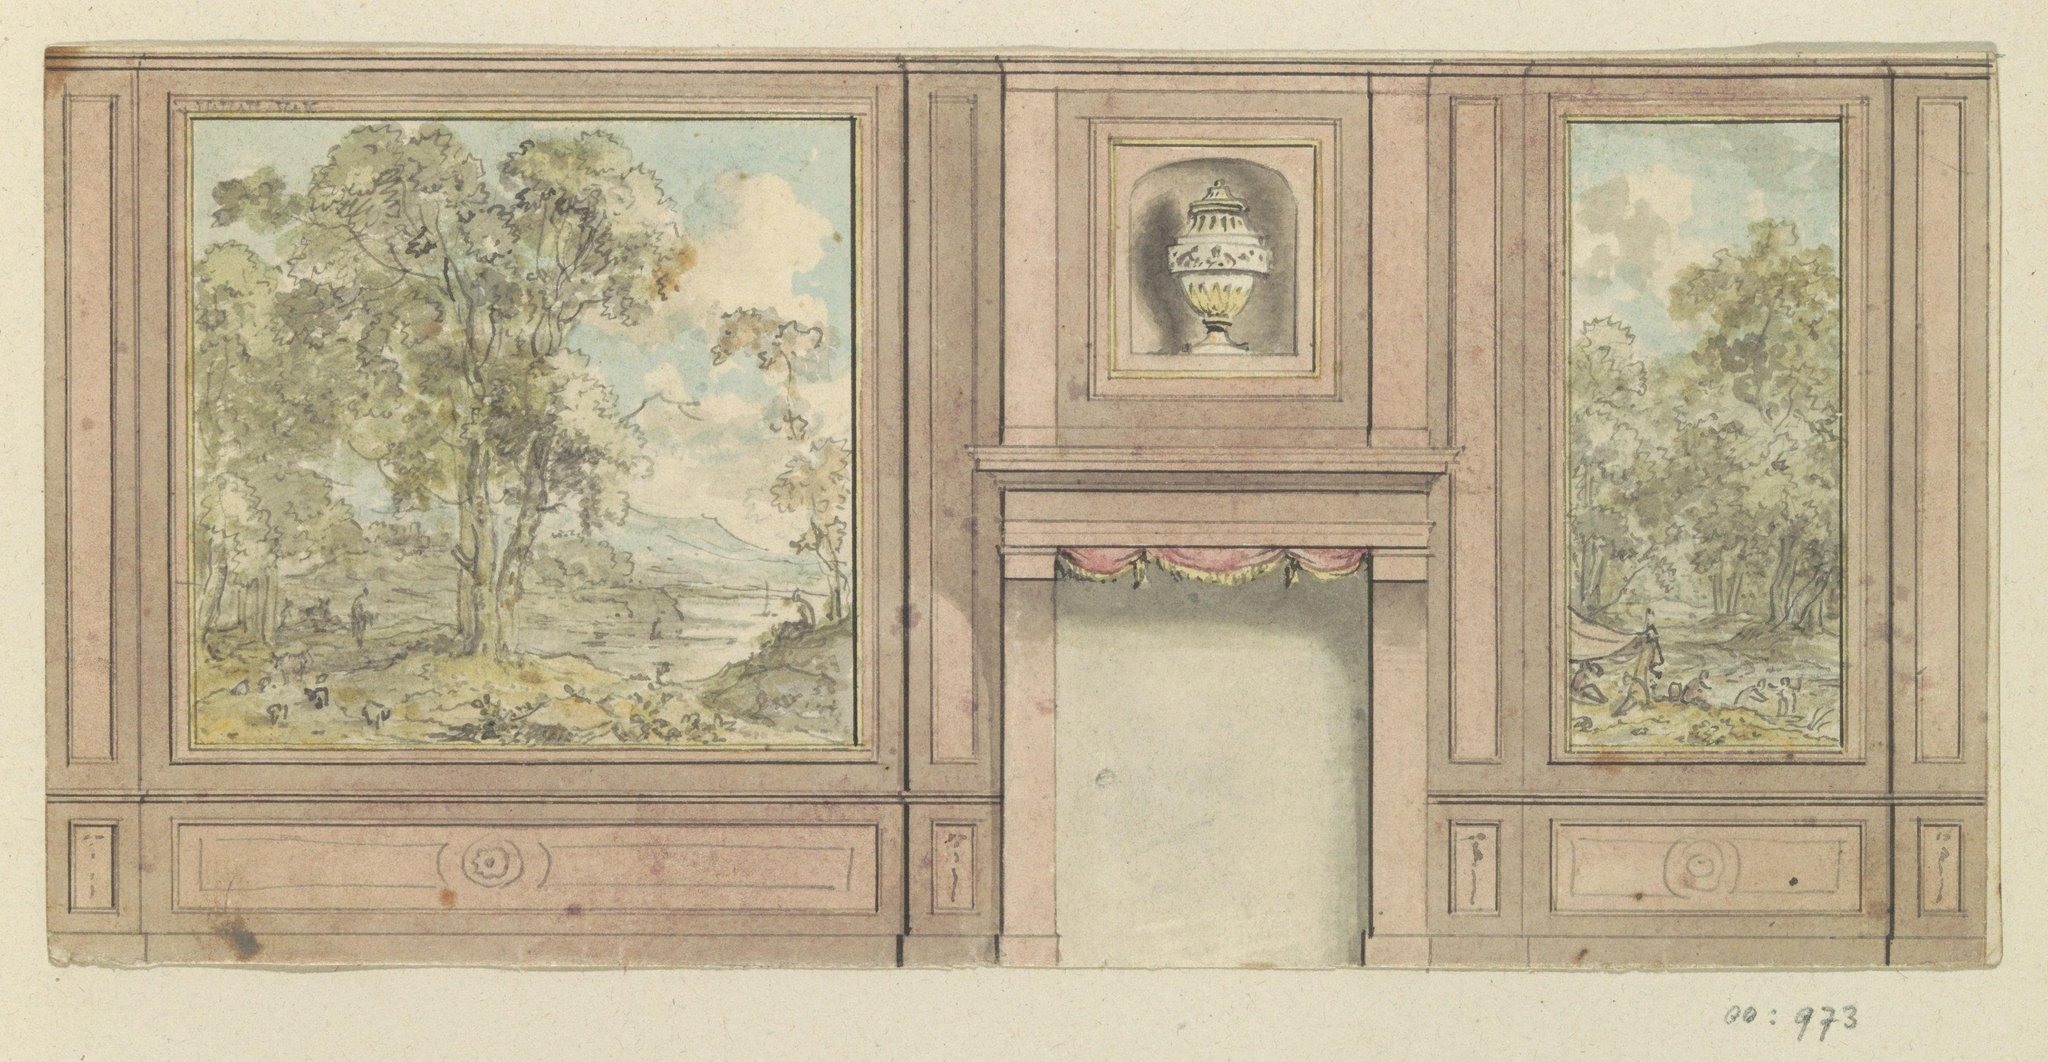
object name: drawing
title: Ontwerptekening voor een kamerwand met schouw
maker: jurriaan andriessen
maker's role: draughtsman, painter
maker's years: 1742-1819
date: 1760-1819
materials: paint, paper, pencil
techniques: brush, pen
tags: landscapes in the temperate zone, forest, wood, chimney-piece, mantelpiece, wall-covering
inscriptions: inscription: ‘voor den Heer/ van Mourik’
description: Met aan weerszijden van de schouw een boslandschap en boven de schouw een bokaal. Tekening maakt deel uit van een album.